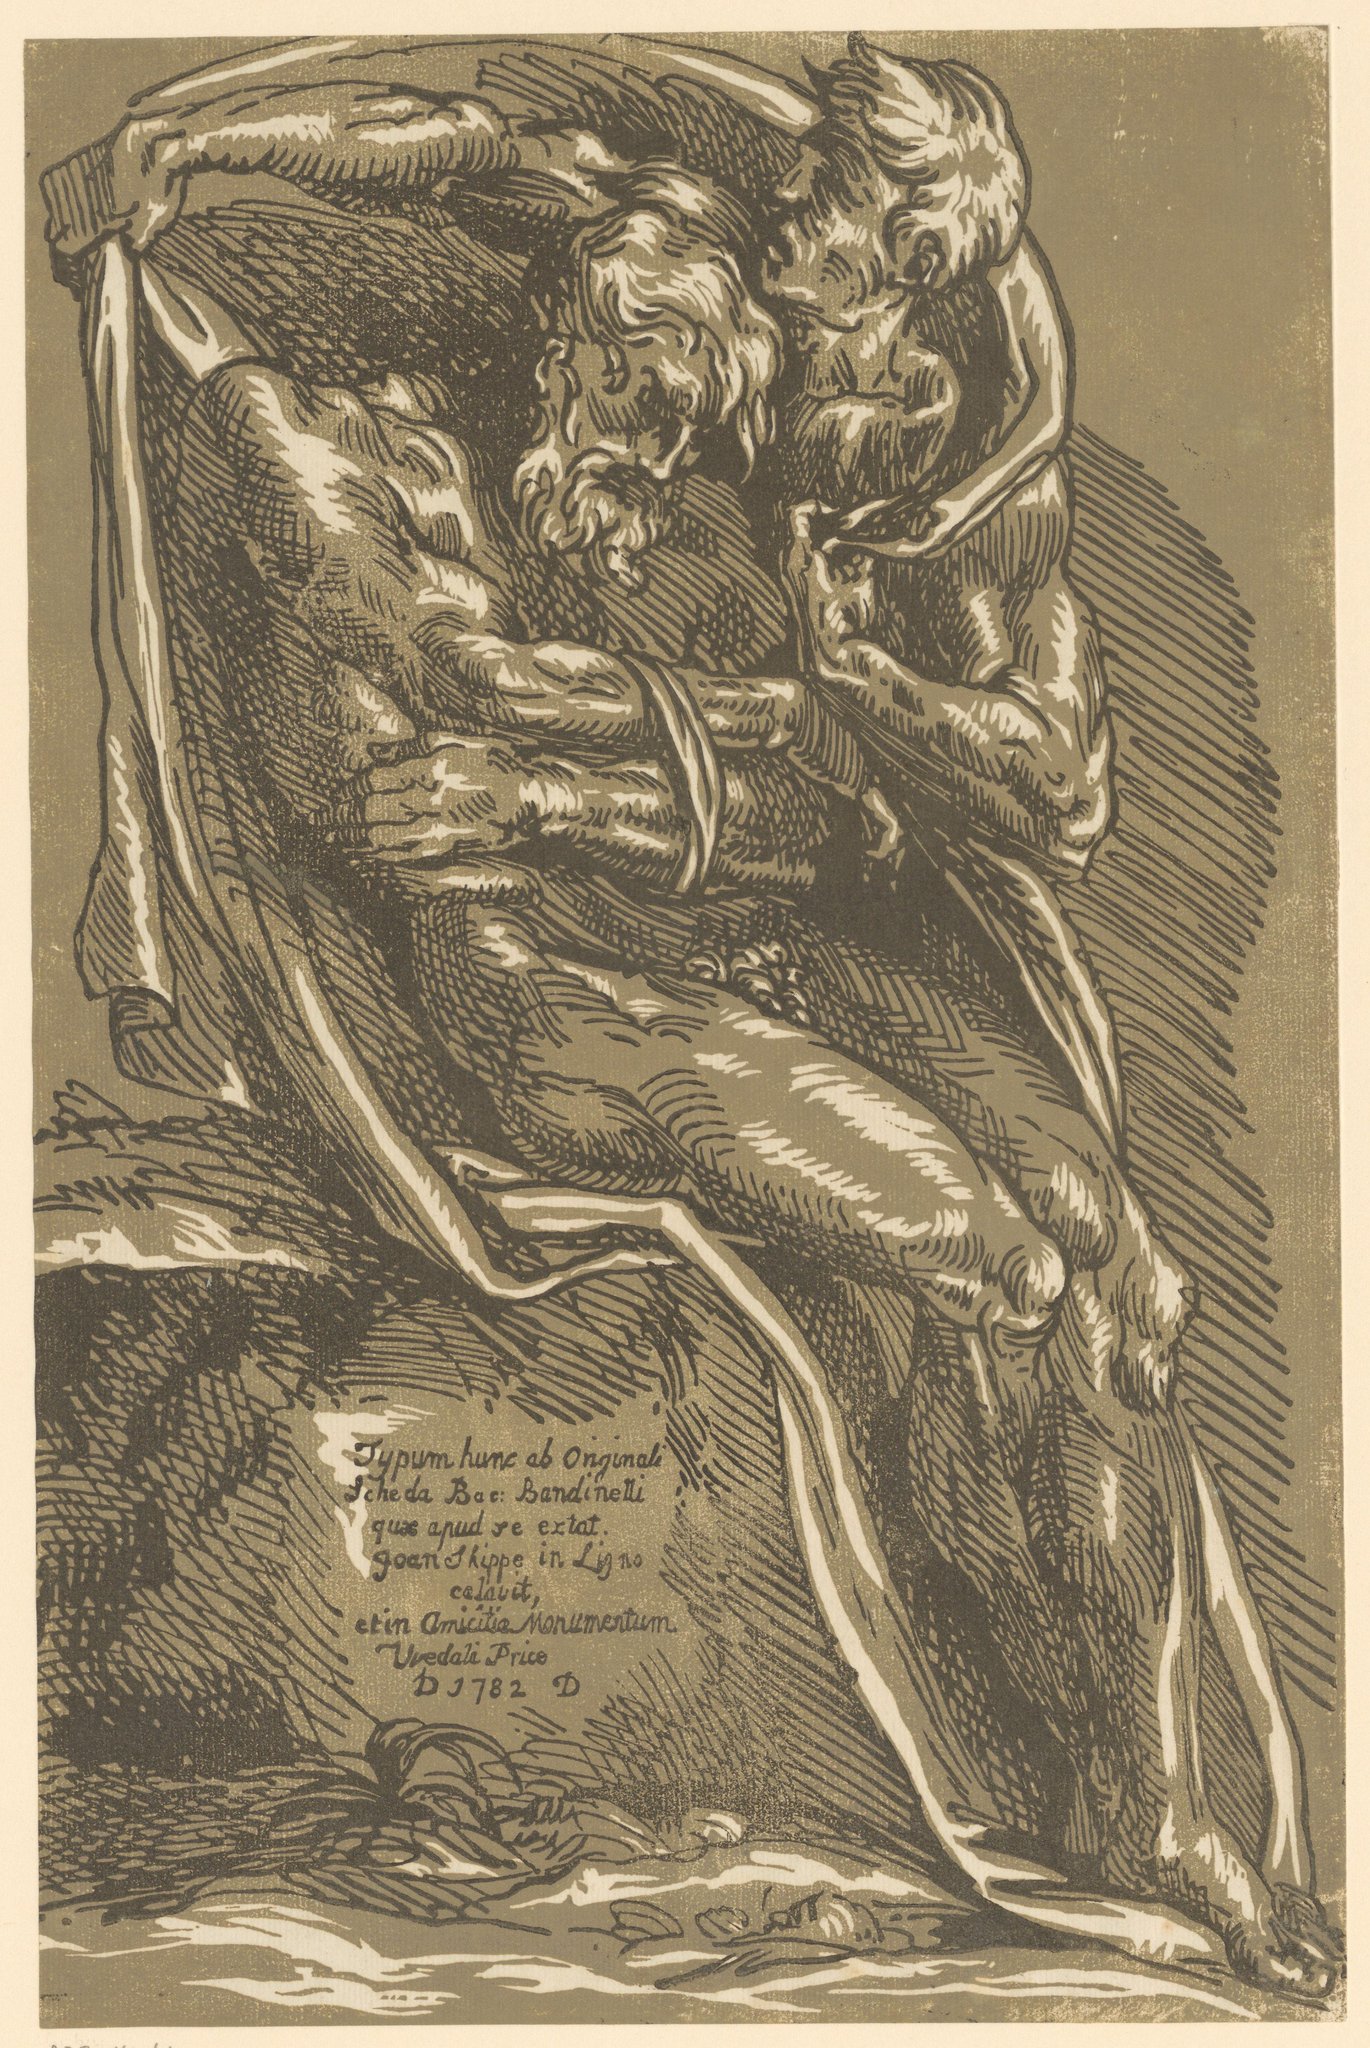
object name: print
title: Man slaat een mantel om een oude man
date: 1782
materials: paper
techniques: woodcut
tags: adult man, old man, coat, cape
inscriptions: collector's mark: Lugt 2228